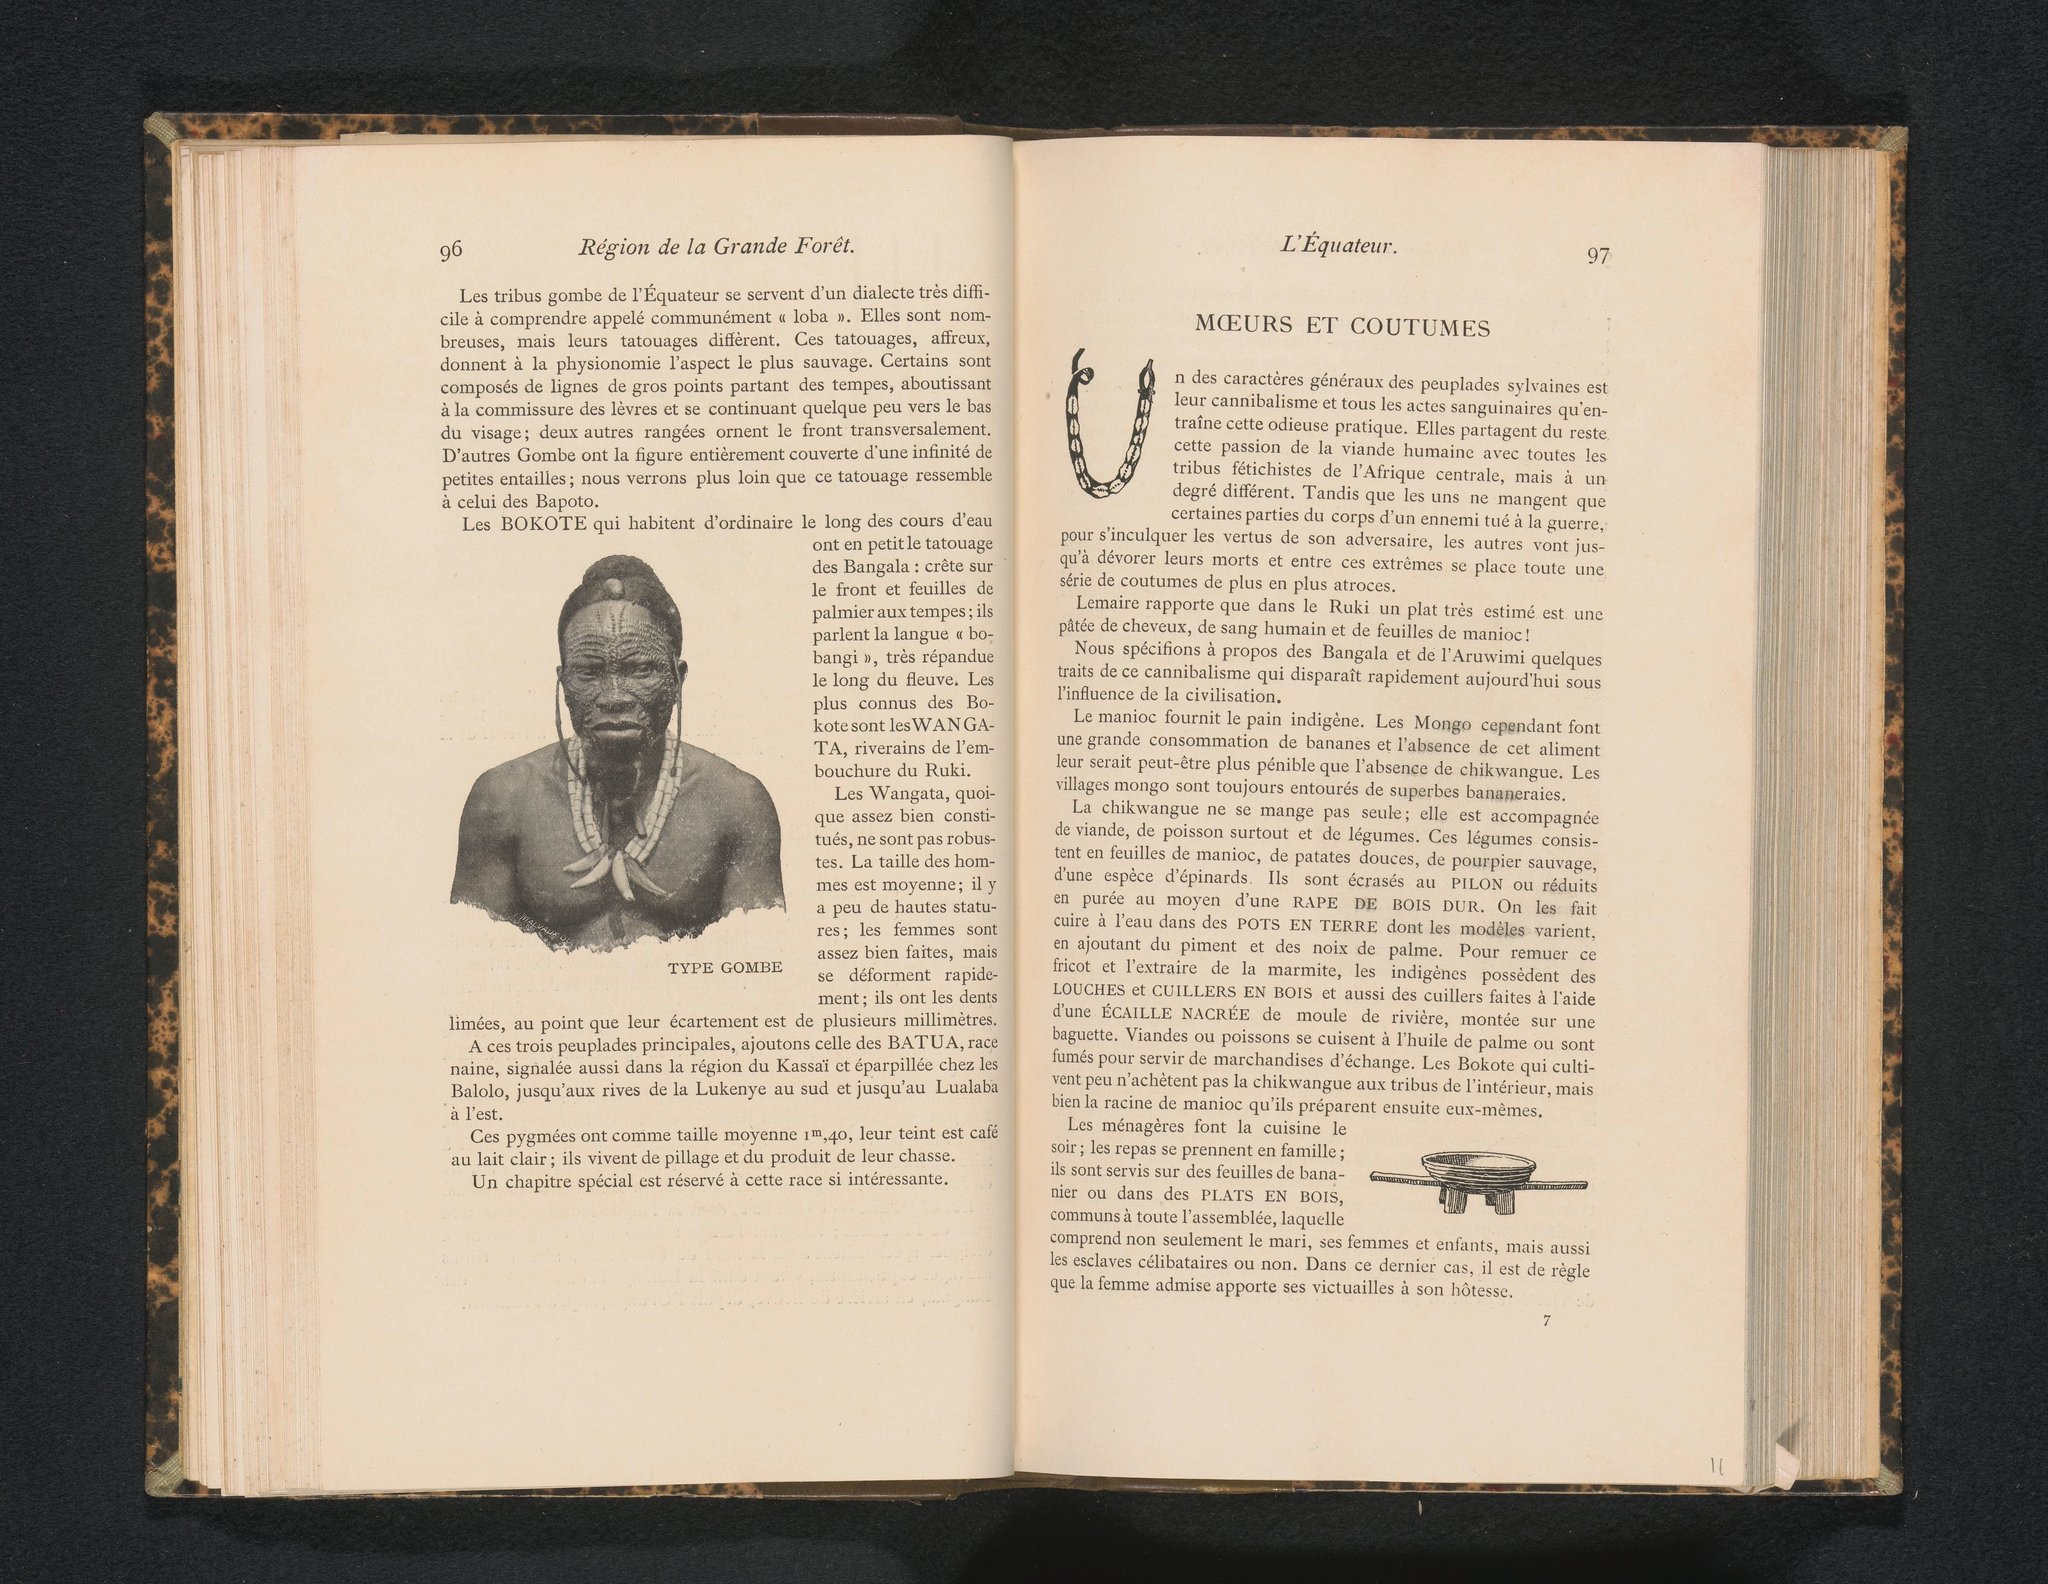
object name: page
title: Type Gombe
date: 1892-1897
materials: paper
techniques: autotype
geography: congo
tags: historical persons